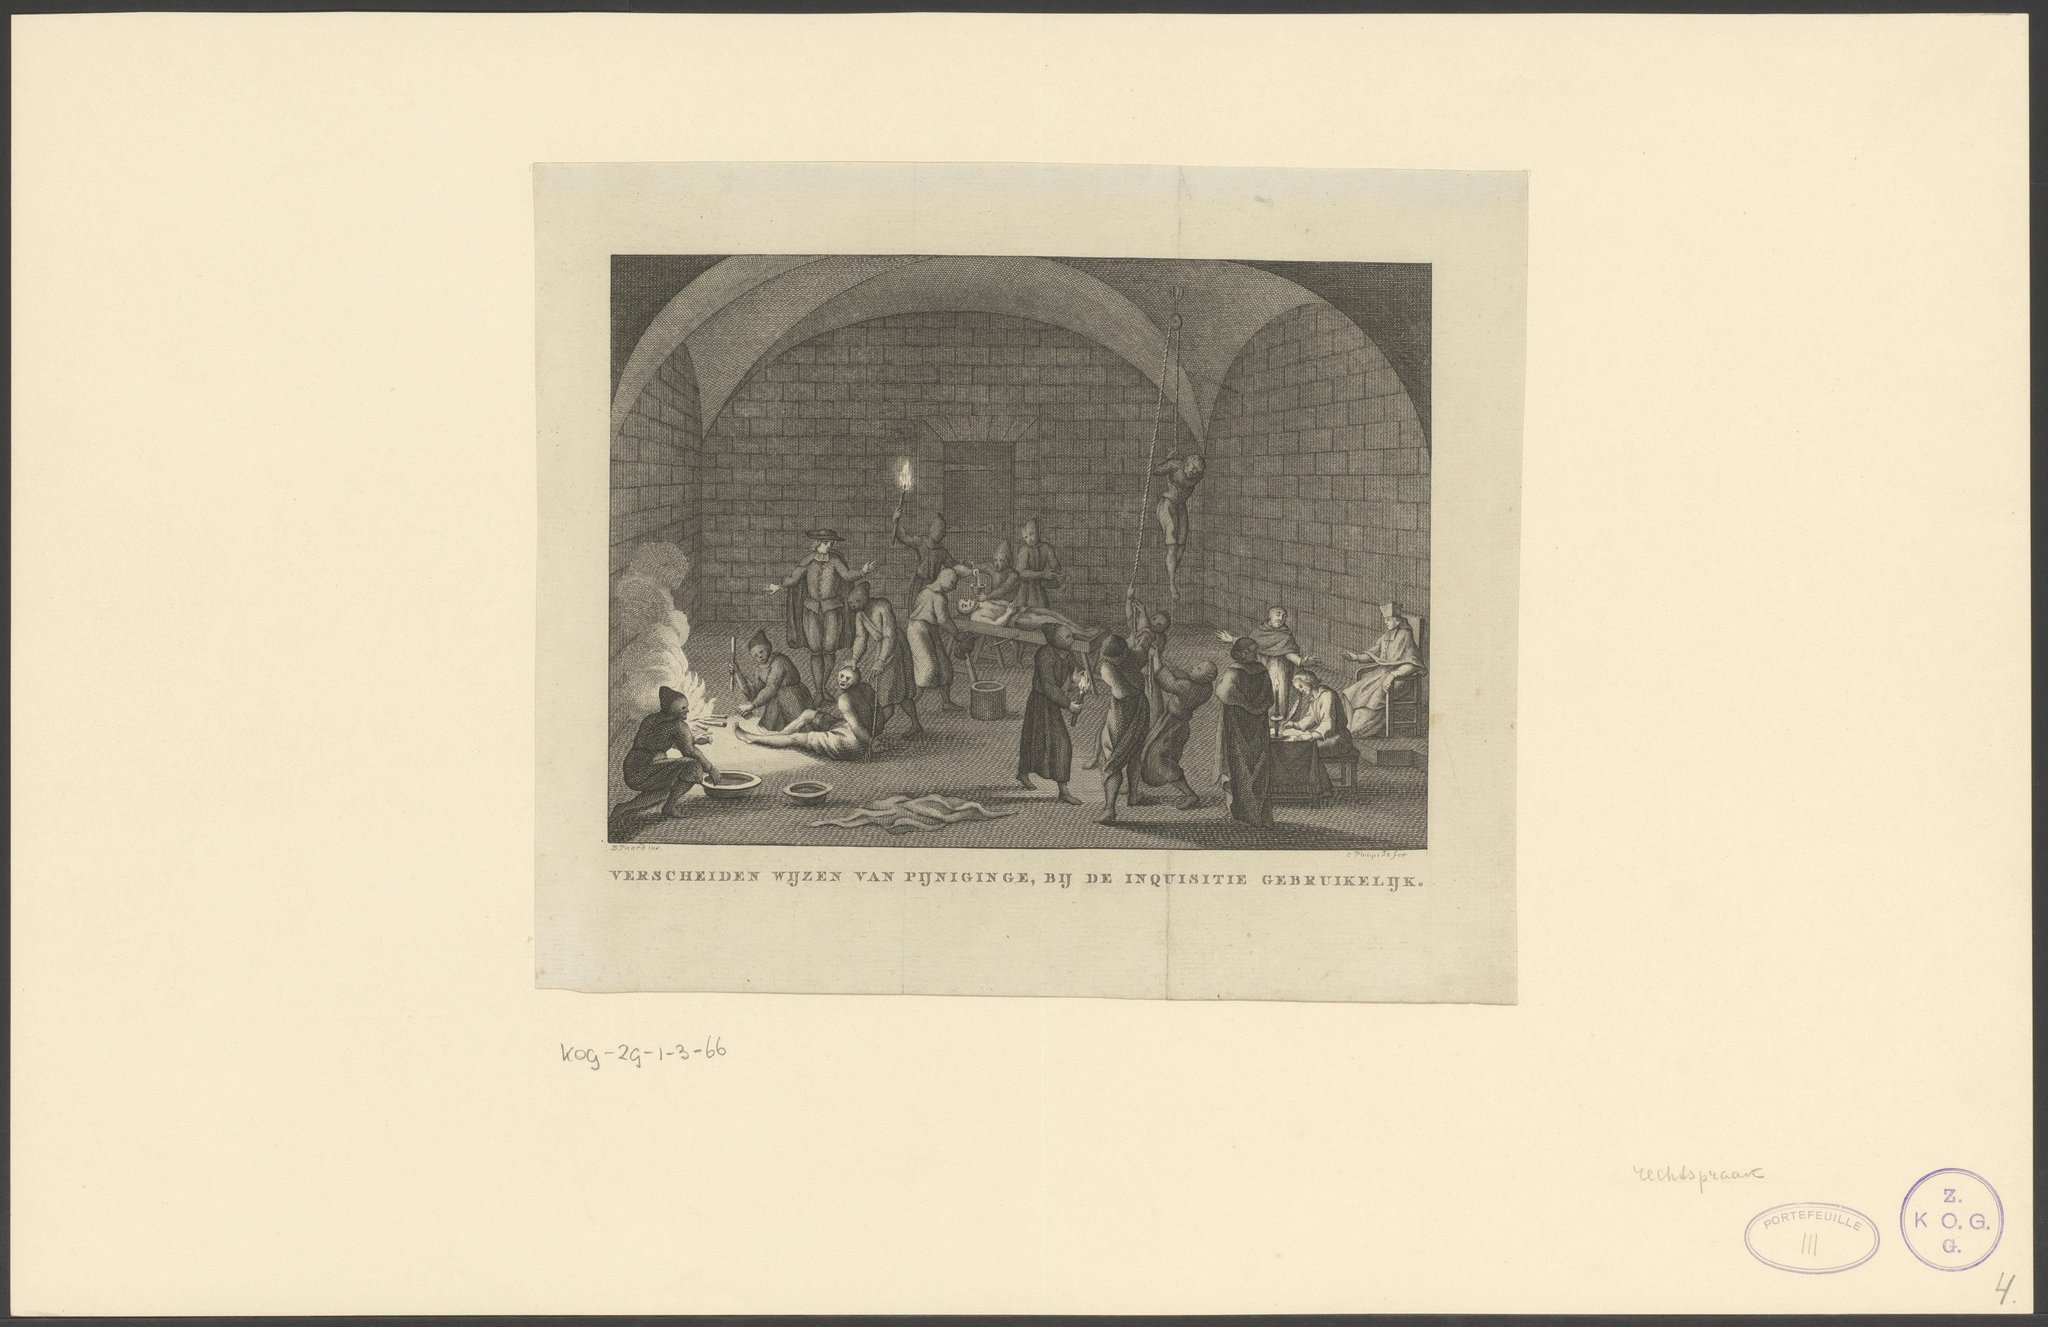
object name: print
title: Verscheiden wijzen van pijninge, bij de inquisitie gebruikelijk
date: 1782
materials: paper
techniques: engraving, etching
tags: torture, inquisition, persecution of believers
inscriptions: collector's mark: Lugt 1641, stamp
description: Prent mogelijk uit: Hurd, William. Oude en tegenwoordige Staat en geschiedenis van alle godsdiensten, van de schepping af tot op den Tegenwoordigen tijd. Amsterdam: Martinus de Bruyn, 1782, dl. 3.